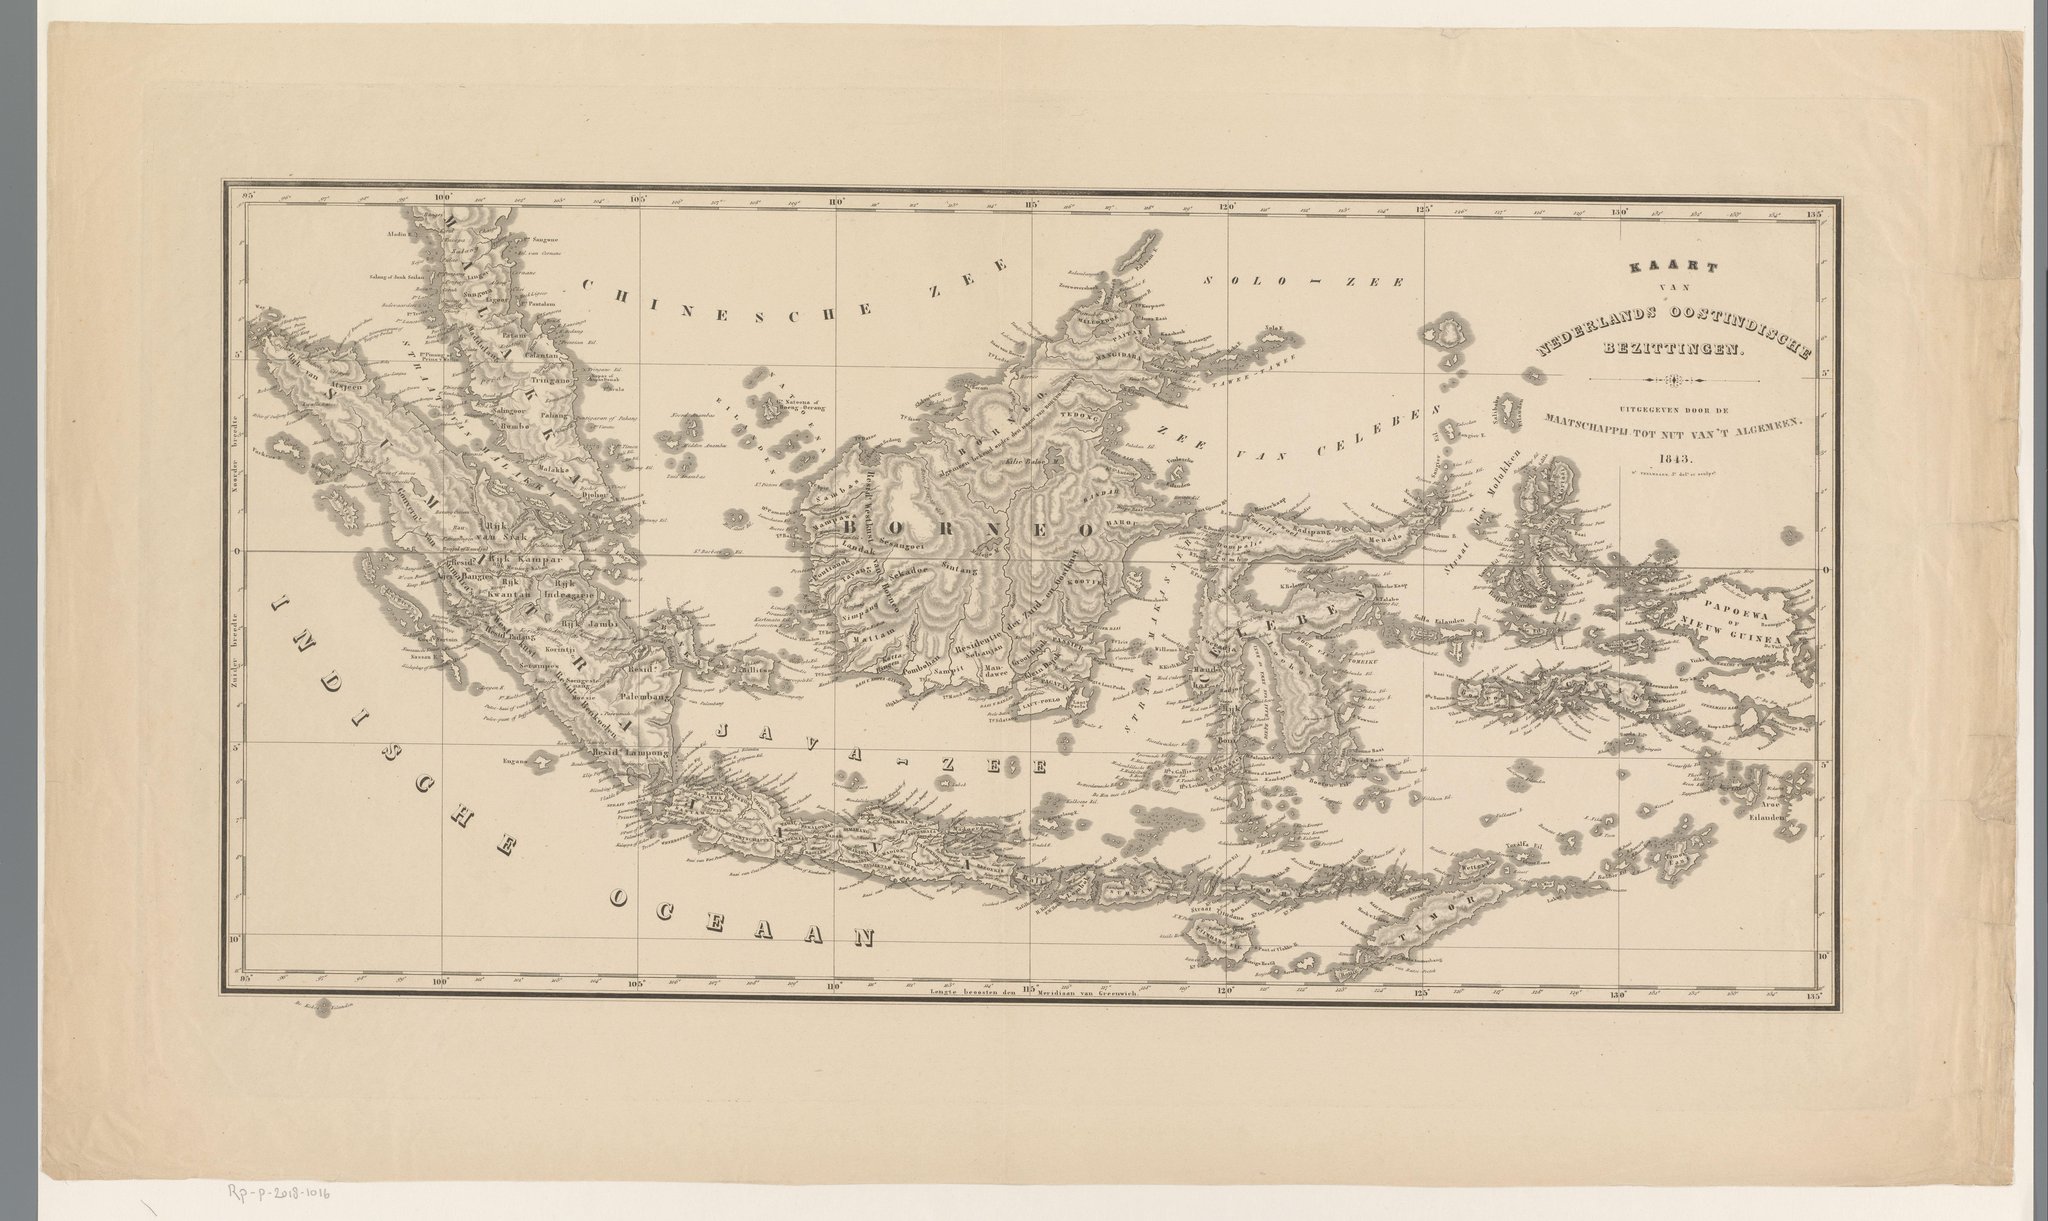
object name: print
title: Kaart van Nederlands Oostindische bezittingen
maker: daniël veelwaard (ii)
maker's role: print maker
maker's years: 1796-1868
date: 1843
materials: paper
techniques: engraving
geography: amsterdam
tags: maps of separate countries or regions, dutch east indies, the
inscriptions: date